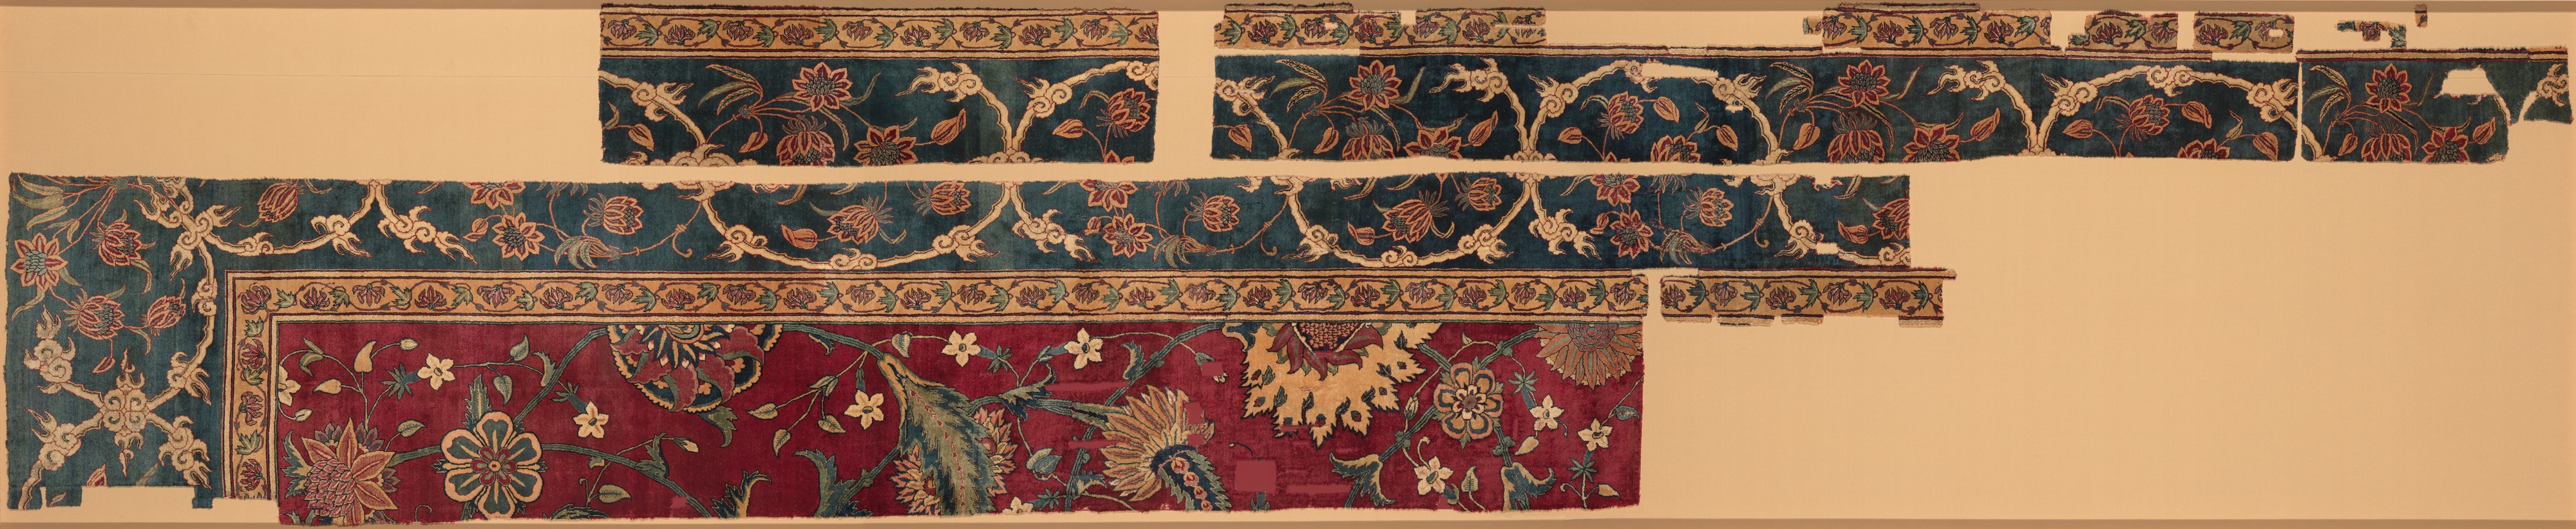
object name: carpet fragment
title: Fragments of a Carpet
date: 1634-1666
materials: silk, wool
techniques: asymmetrically knotted pile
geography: india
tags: flowers